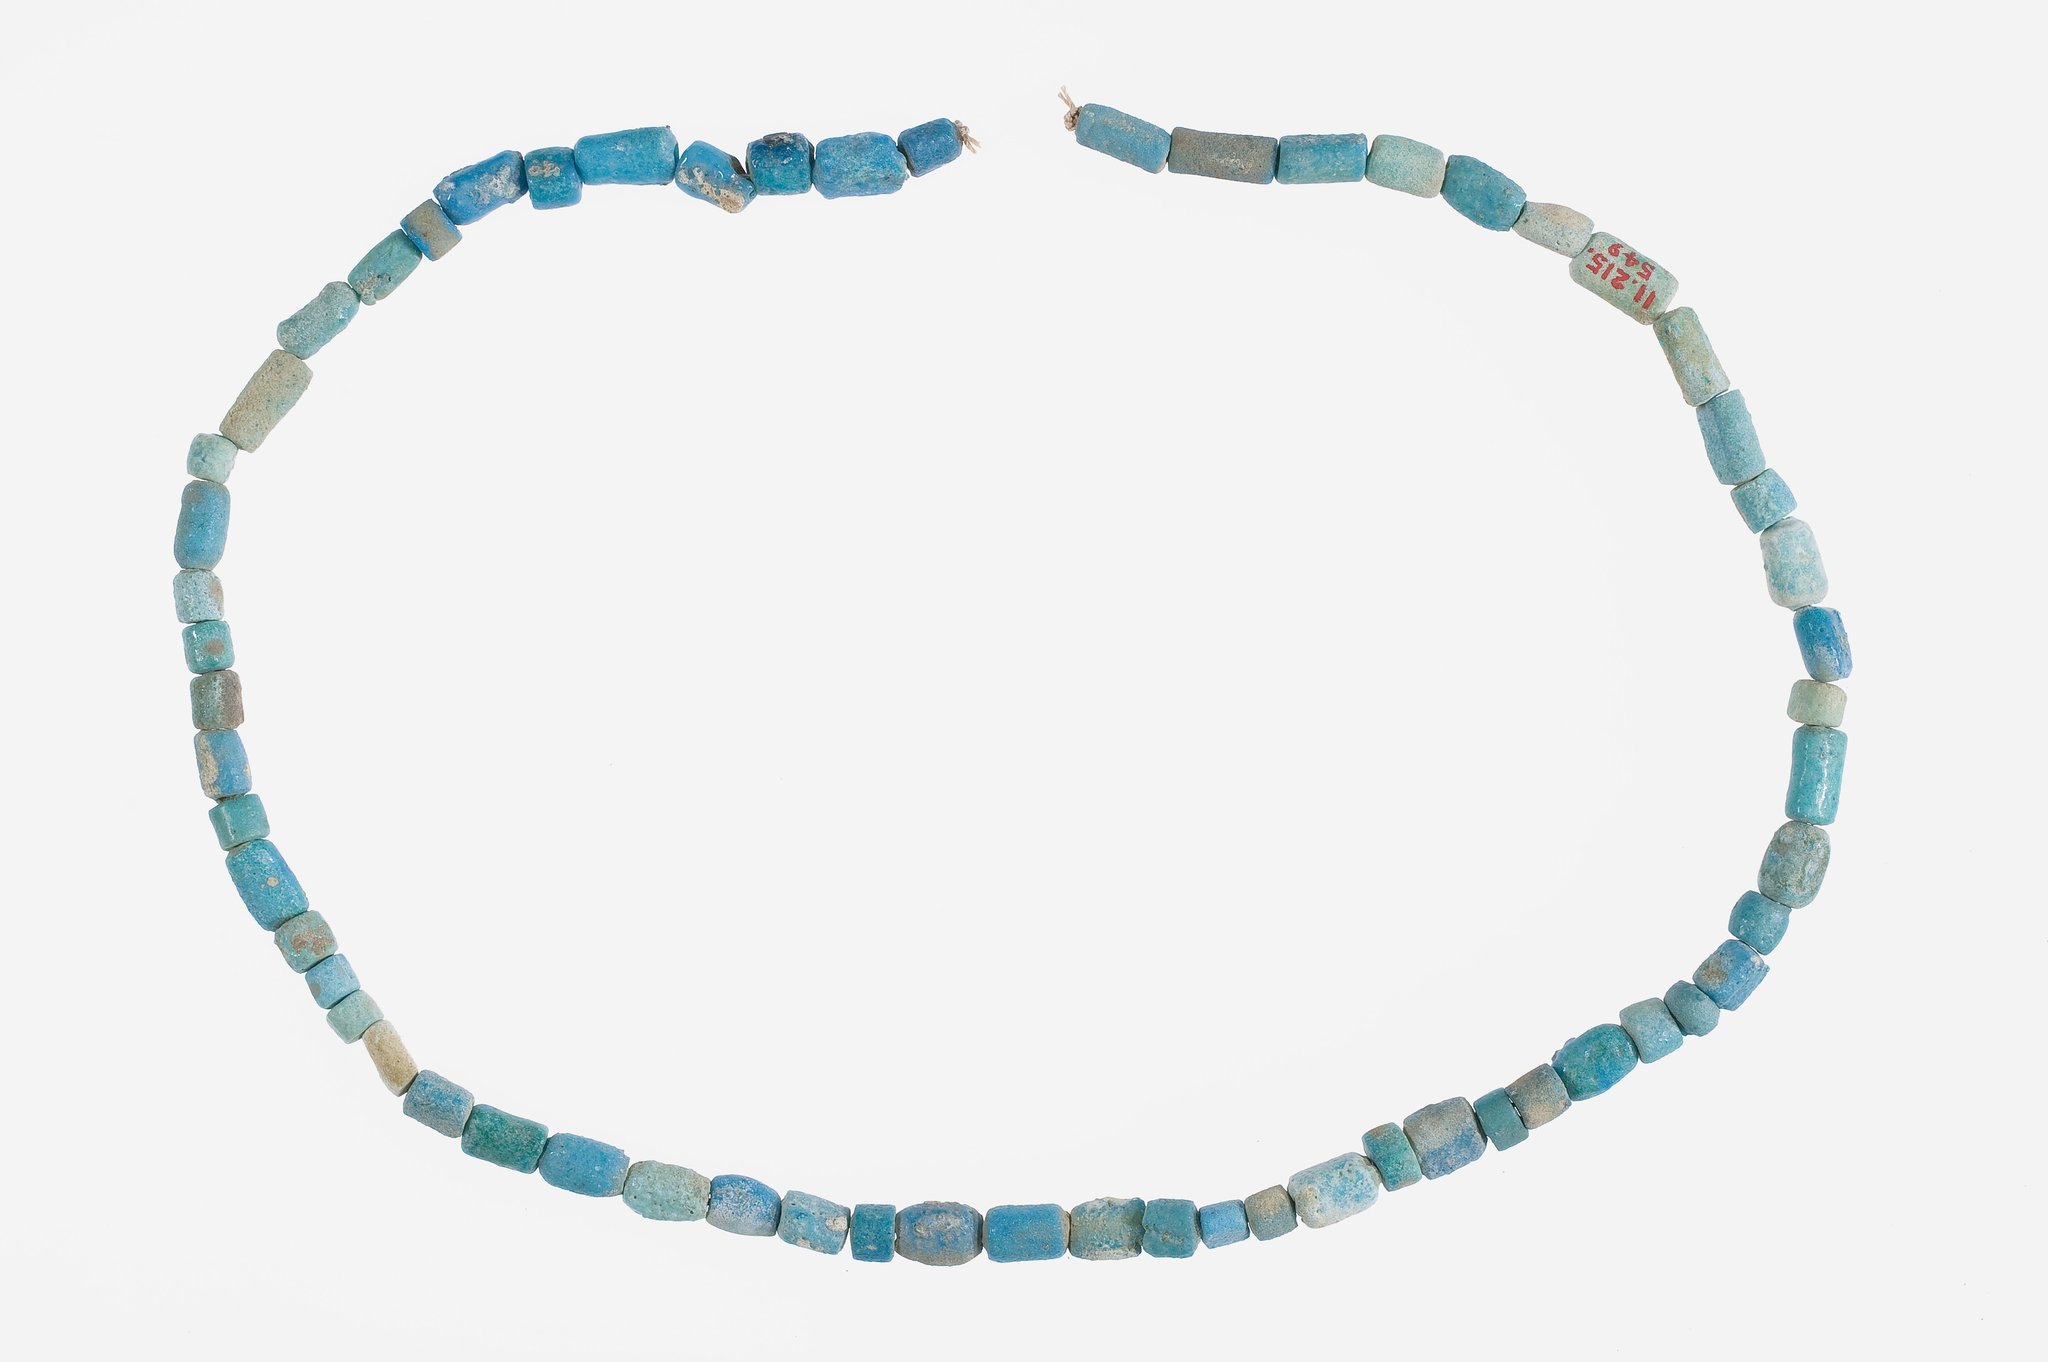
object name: bead, cylinder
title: String of Short Cylindrical Beads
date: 1390-1352 BCE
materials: faience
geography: egypt